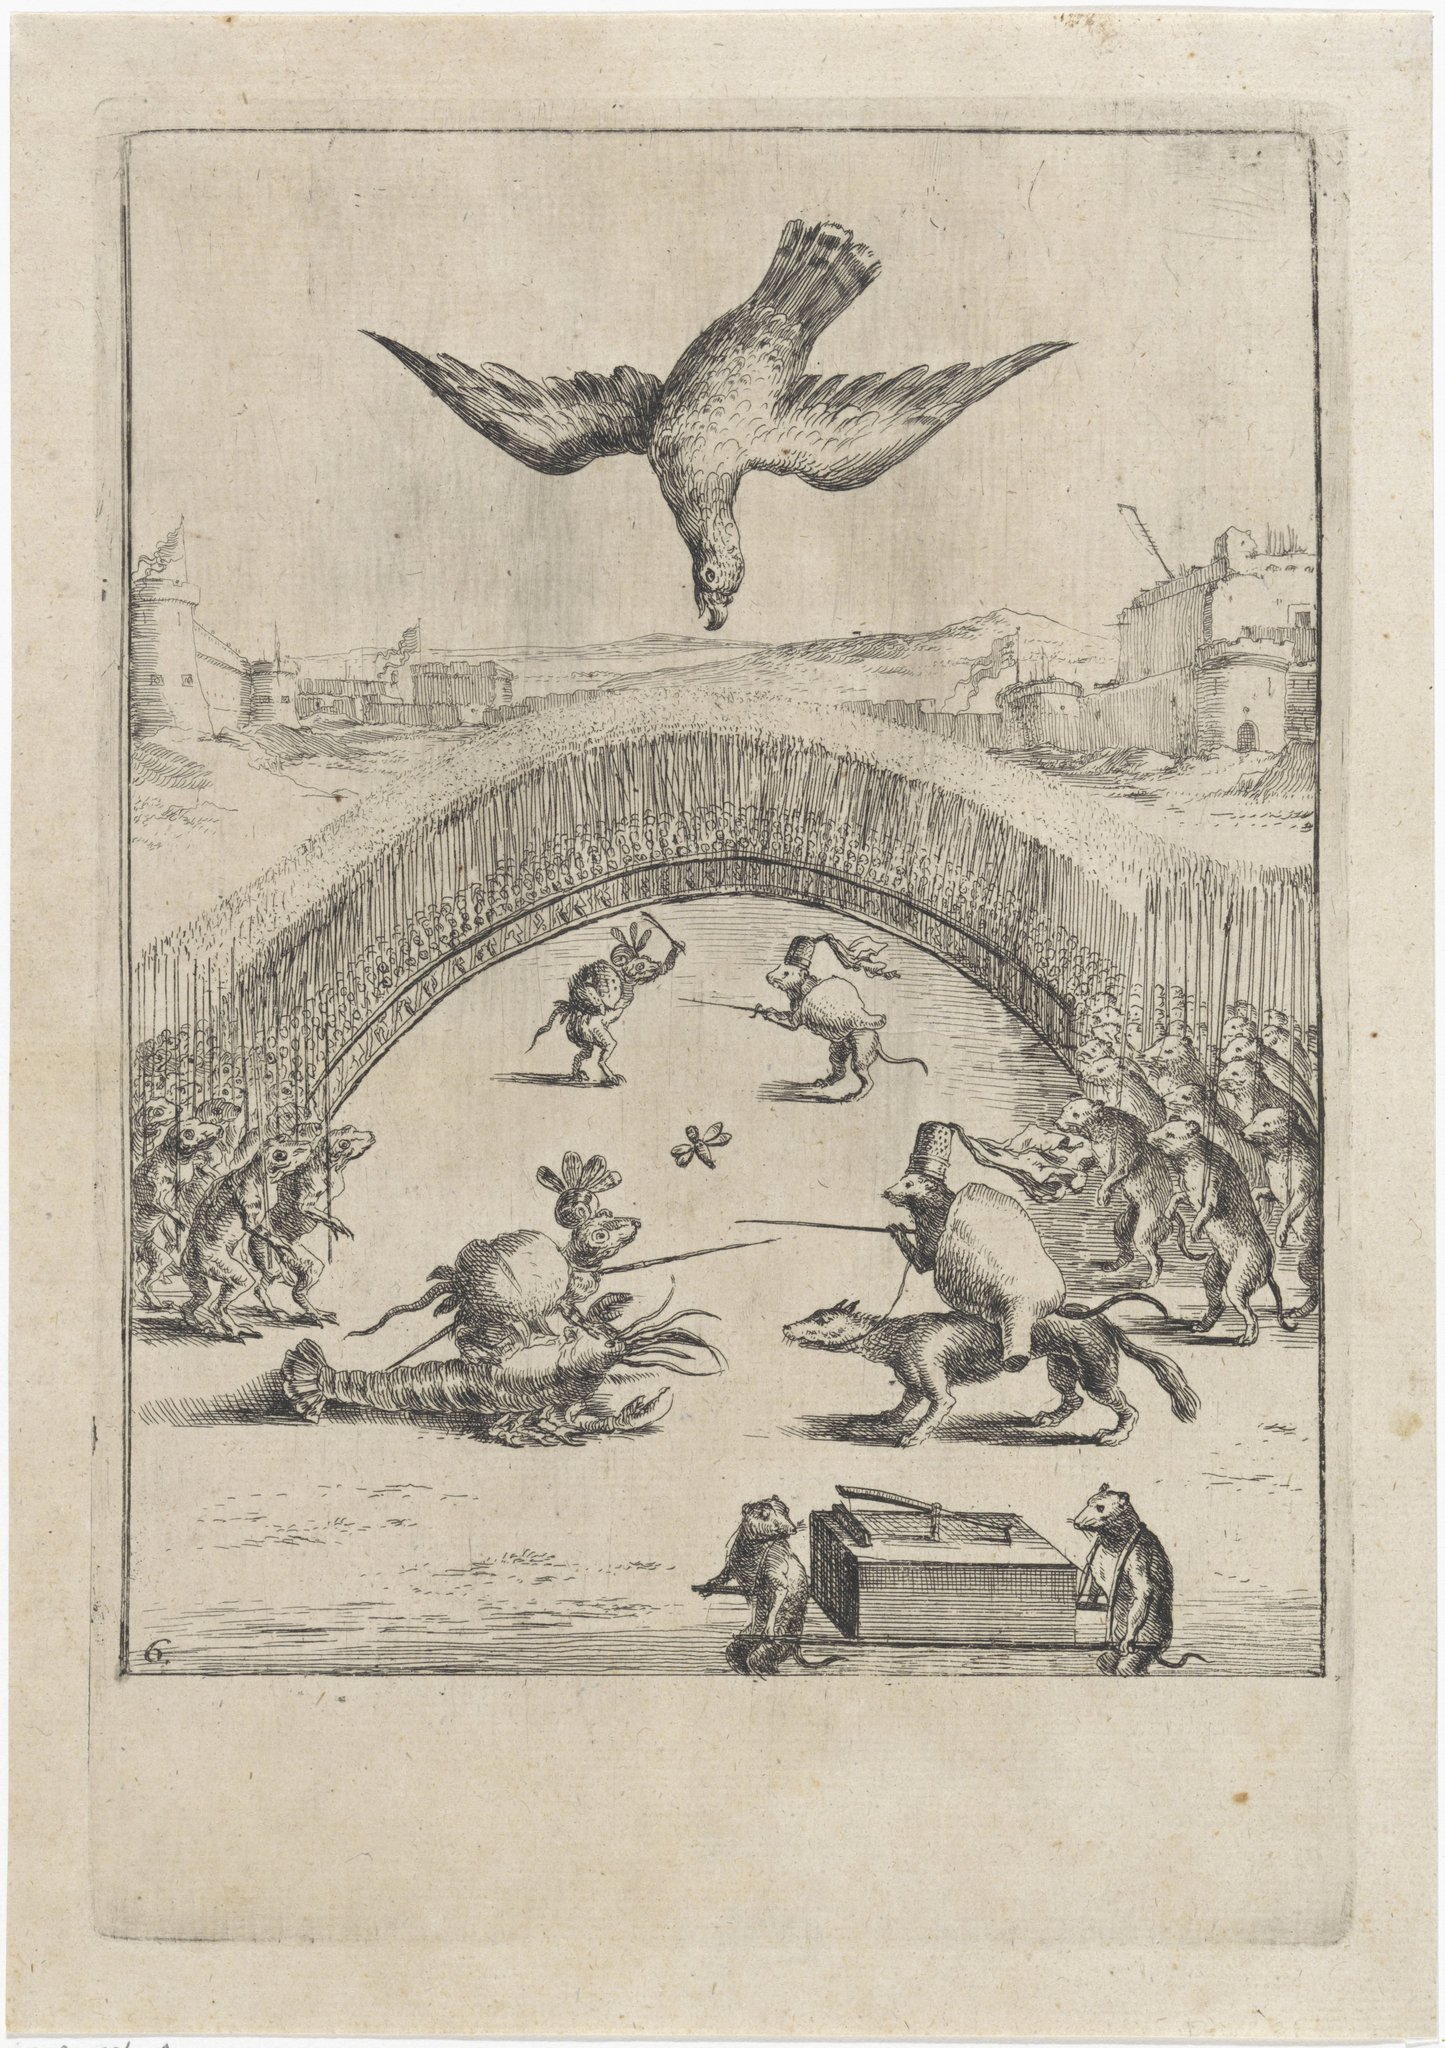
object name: book illustration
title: Fabels van Aesopus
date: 1665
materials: paper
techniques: etching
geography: london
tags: tailless amphibians: frog, rodents: mouse, predatory birds: hawk, fables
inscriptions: collector's mark: Lugt 2228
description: Op een slagveld, omringd door een leger kikkers aan de ene kant en een leger muizen aan de andere kant, gaan een kikker rijdend op een kreeft en een muis rijdend op een vos elkaar te lijf. Terwijl ze in hun strijd opgaan komt er een havik aanvliegen, die het op beiden heeft gemunt. Illustratie van een fabel van Aesopus.